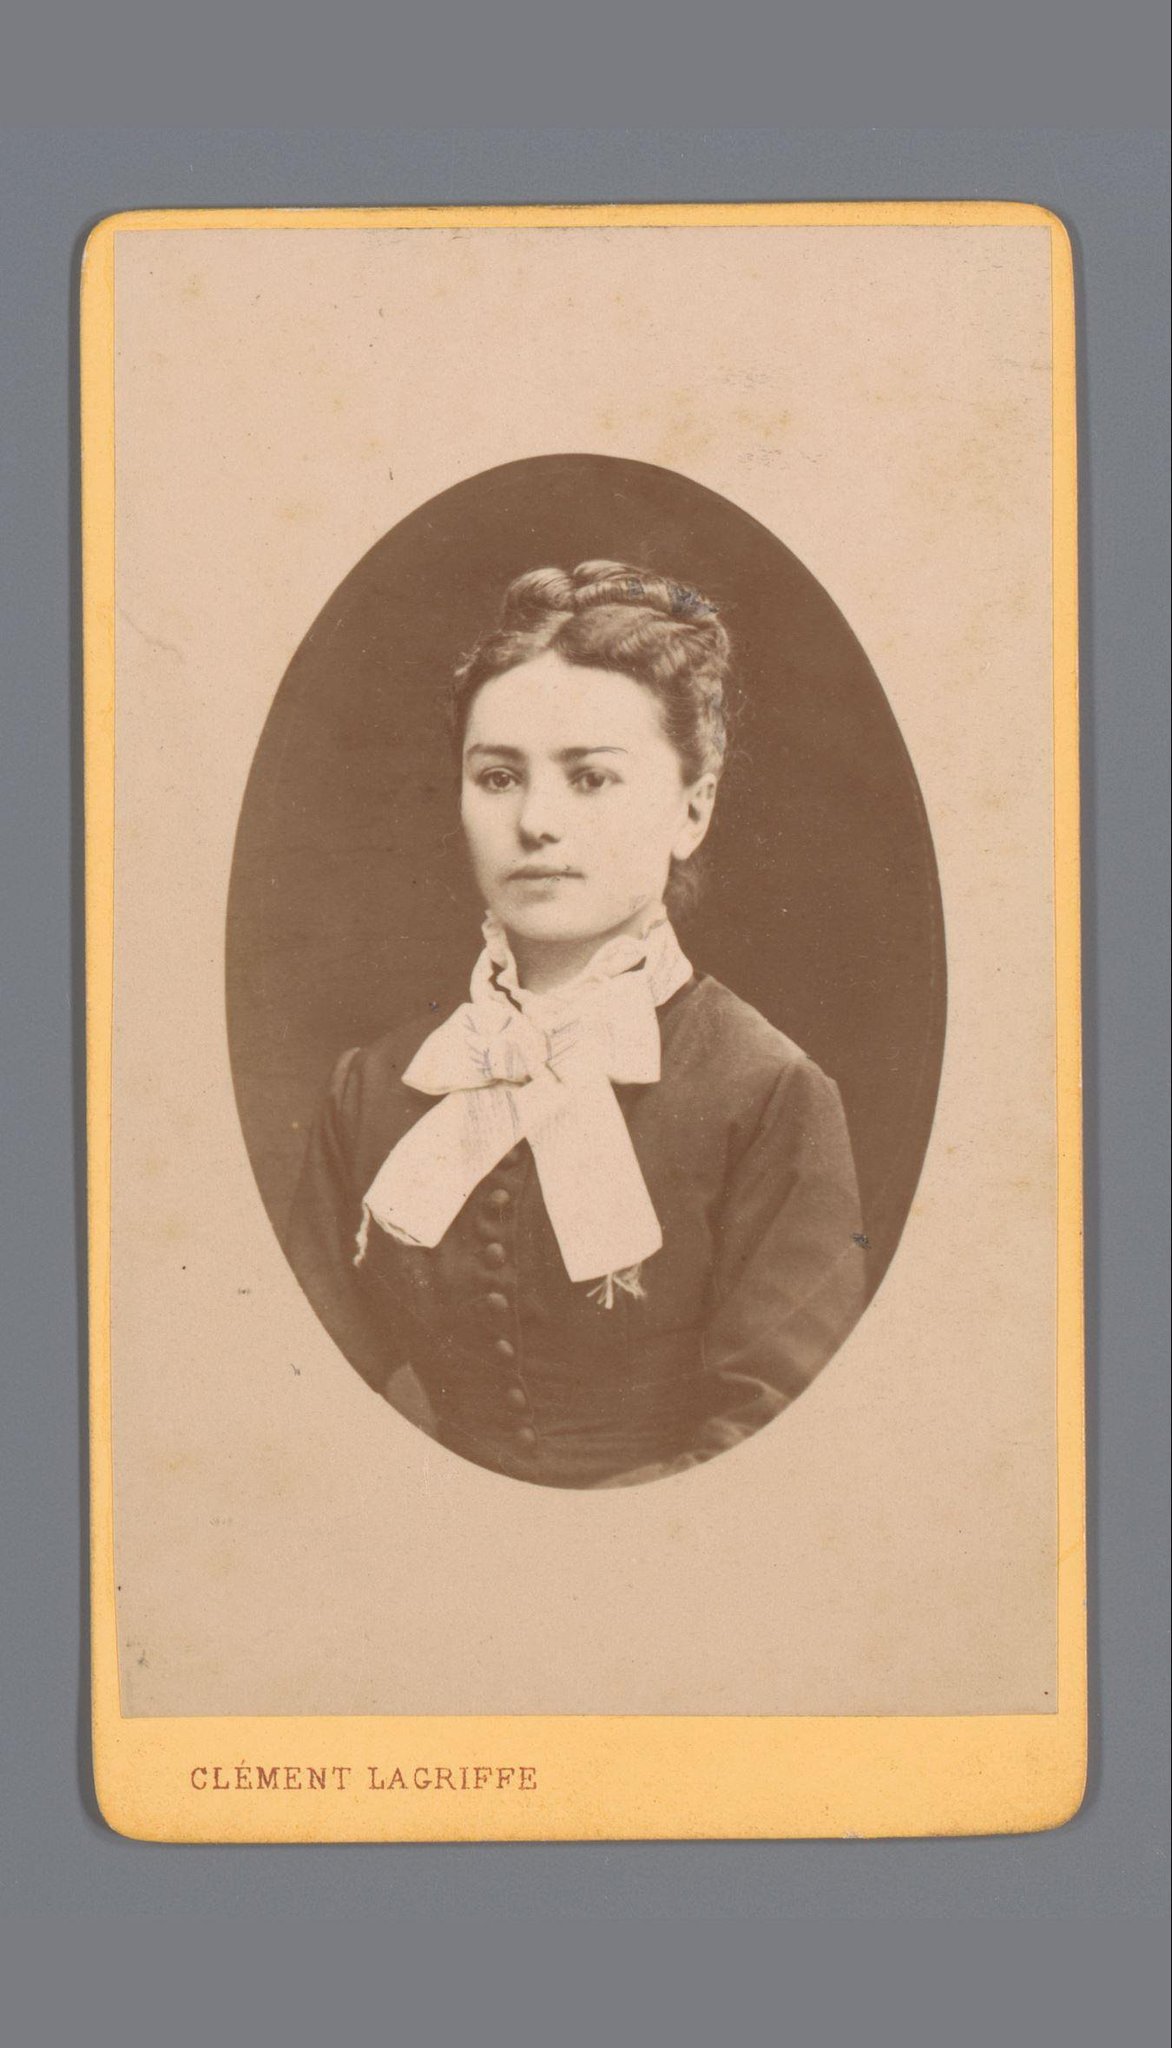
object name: photograph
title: Portret van een onbekende jonge vrouw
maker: jaques clément lagriffe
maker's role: fotograaf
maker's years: 1828-1899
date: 1862-1885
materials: cardboard, paper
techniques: albumen print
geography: paris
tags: adolescent, young woman, maiden, anonymous historical person portrayed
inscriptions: inscription: ‘Tous les Clichés sont conservés et/ peuvent servir pour portraits agrandis/ -77’, address: ‘203. Rue St Honoré, 203./ près St. Roch/ PARIS’